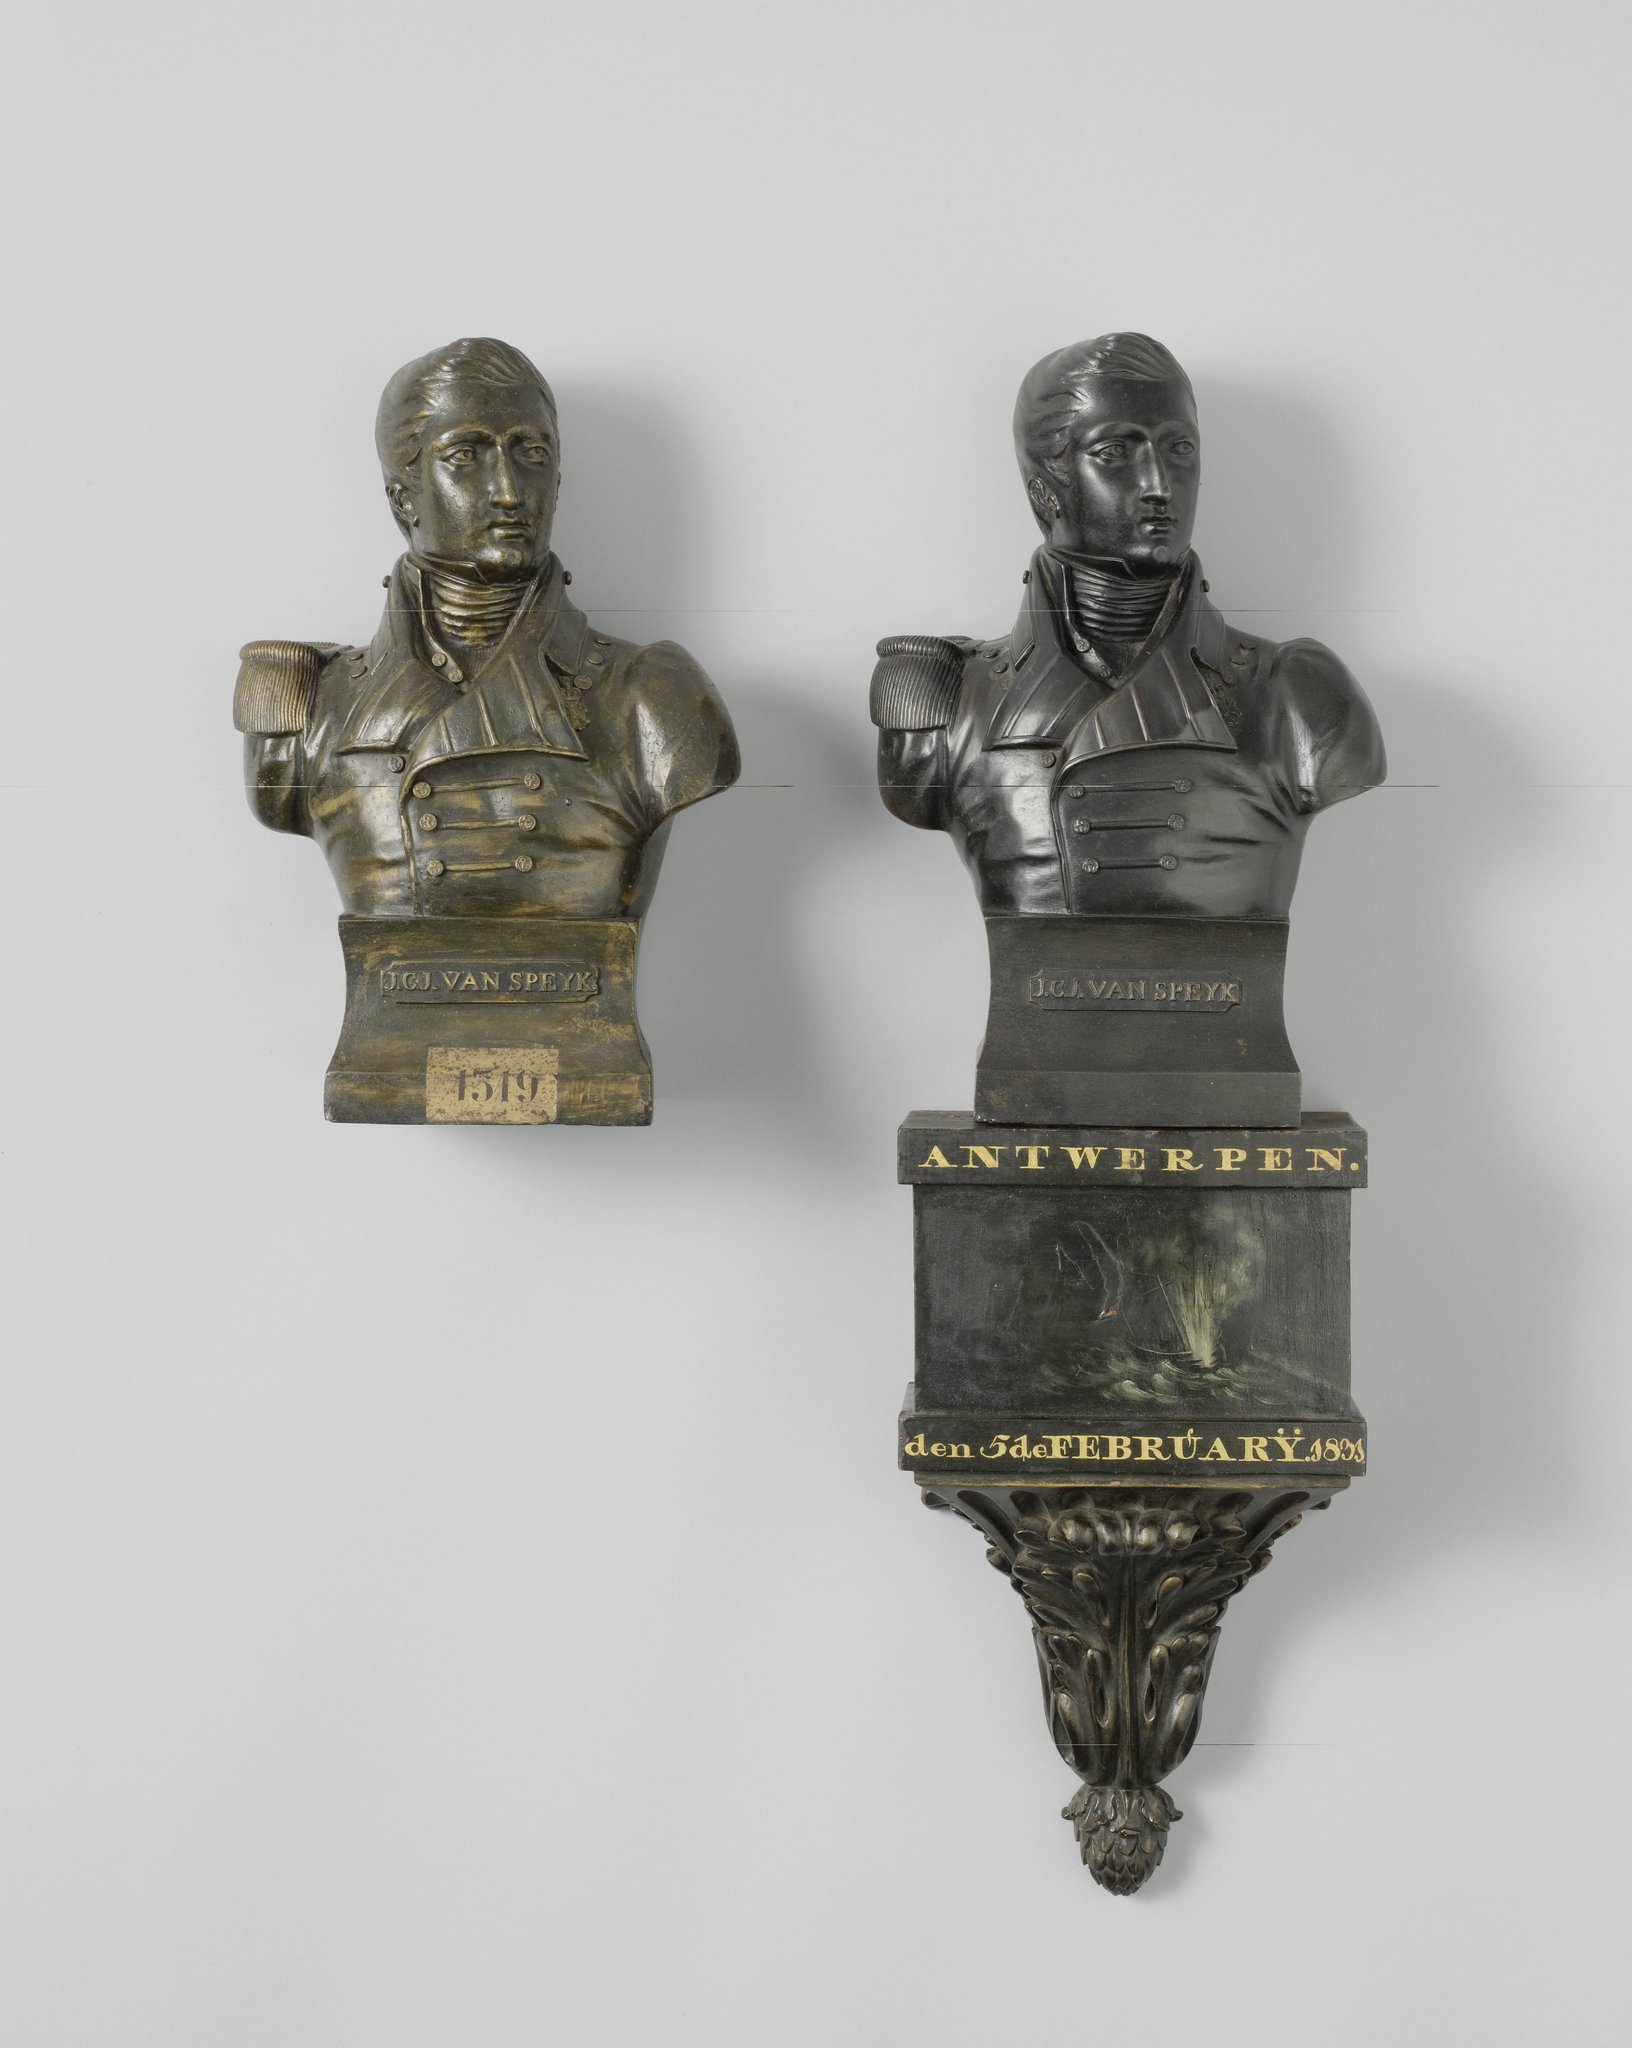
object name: bust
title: Bust of J.C.J. van Speyk (1802-1831)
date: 1832-1858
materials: bronze, iron, wood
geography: netherlands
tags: amsterdam, antwerp, jan van speyk, chest, bust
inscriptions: label, bottom centre: ‘1319’ former inventory label, inscription, on the bust: ‘J.C.J. VAN SPEYK’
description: Twee busten van J.C.J. Van Speyk en één sokkel. Twee identieke bronzen busten van een Nederlands marine-officier, het hoofd licht naar links gedraaid. Hij draagt een uniform en een Militaire Willemsorde. Bij de busten hoort één wandsokkel, waarop de ontploffing van het schip van de geportretteerde is afgebeeld. De sokkel is onderaan met een guirlande afgewerkt.